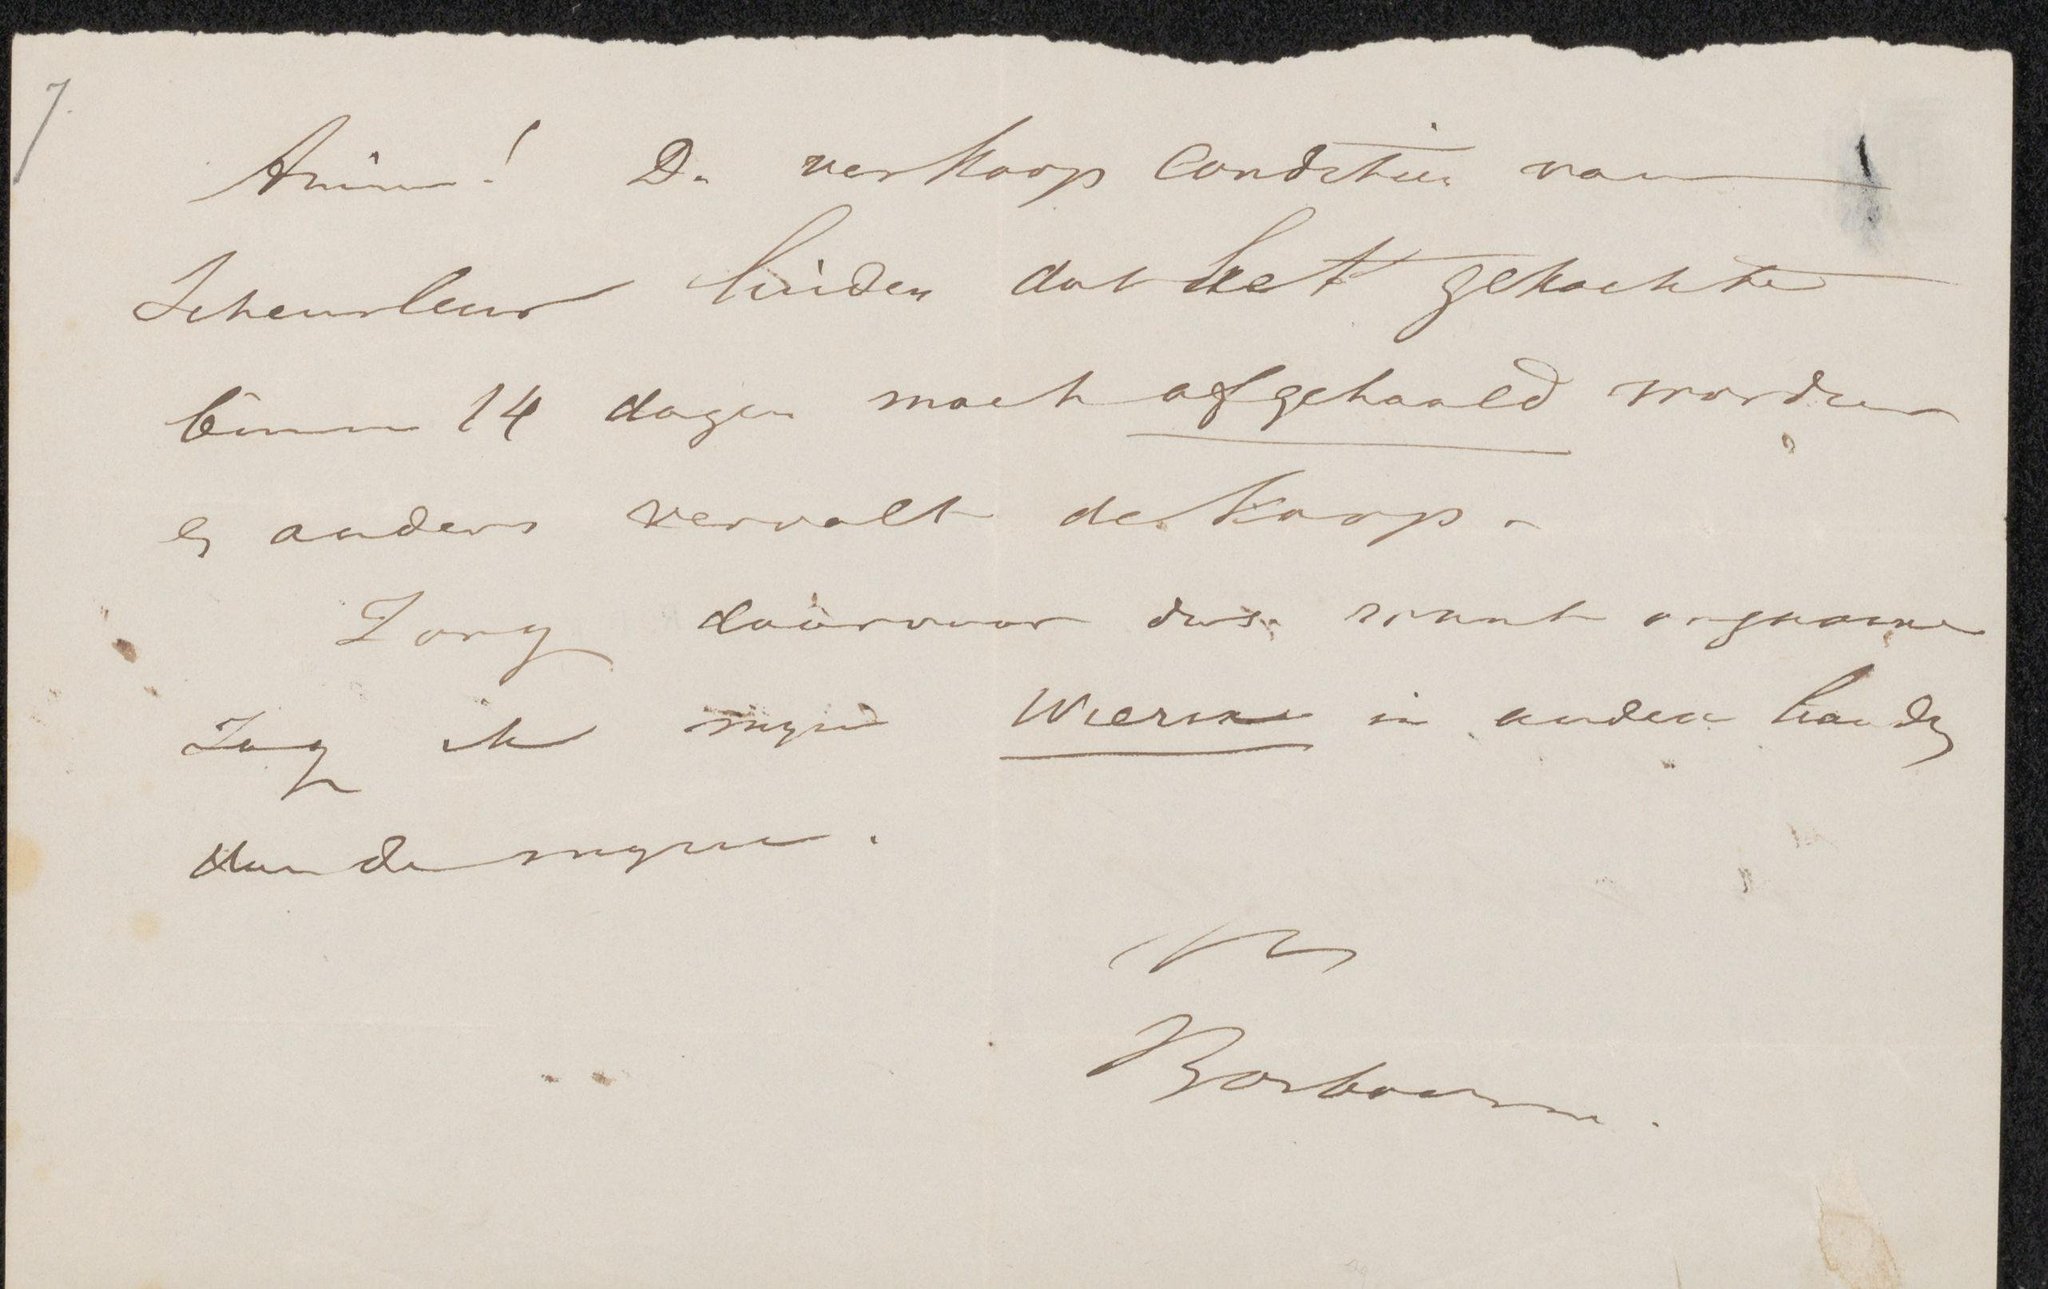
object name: letter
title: Brief aan Jan Weissenbruch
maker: johannes bosboom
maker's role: draughtsman, painter, print maker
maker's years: 1817-1891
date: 1827-1891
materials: ink, paper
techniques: pen, writing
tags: print maker, draughtsman, johannes wierix, the hague, painter, jan weissenbruch, daniël françois scheurleer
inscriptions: collector's mark: Lugt 2233